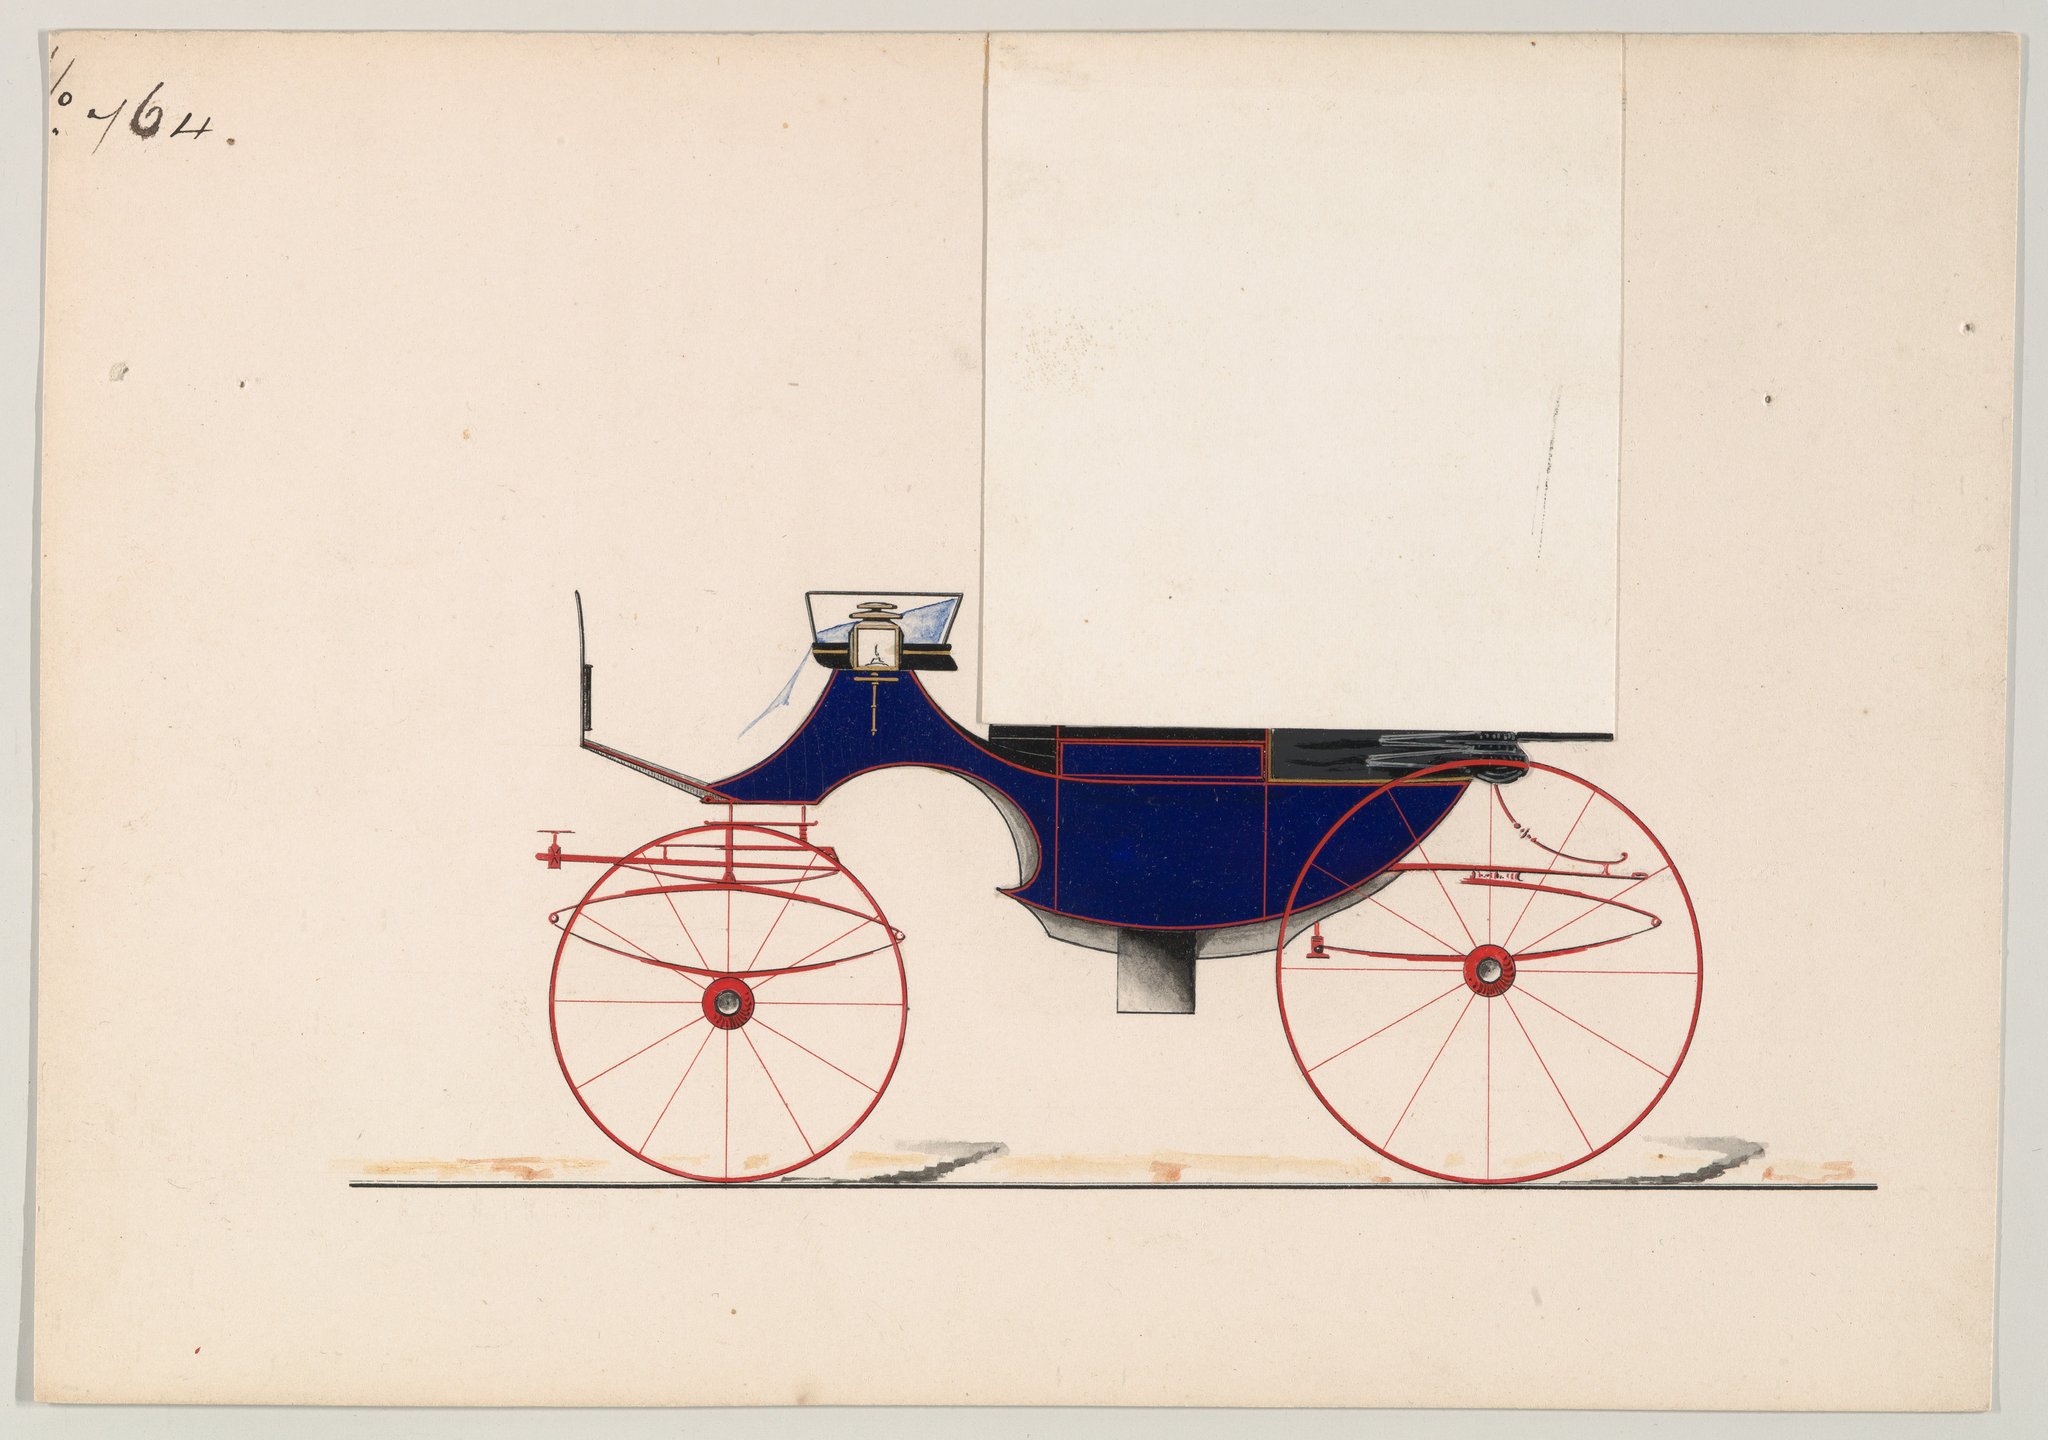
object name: drawing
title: Design for Landaulet, no. 764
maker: brewster & co.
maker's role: manufacturer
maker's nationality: american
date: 1850-1870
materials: gouache, gum arabic, ink, watercolor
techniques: pen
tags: carriages